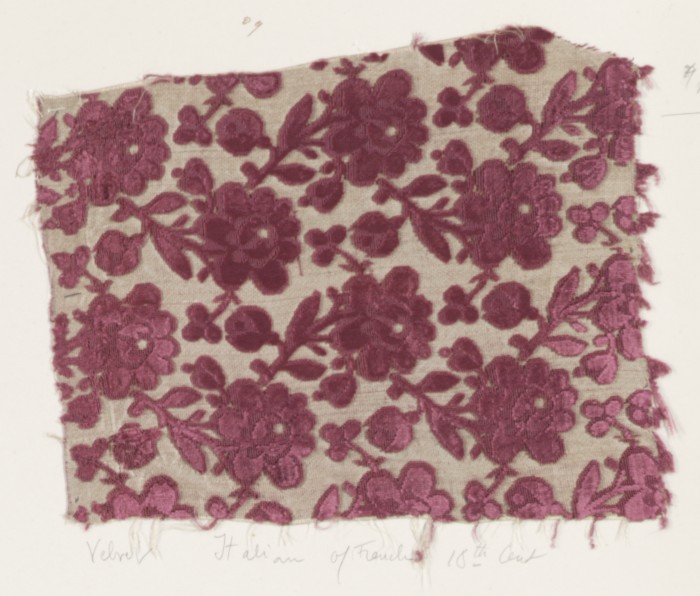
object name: fragment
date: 1701-1800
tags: flowers,leaves